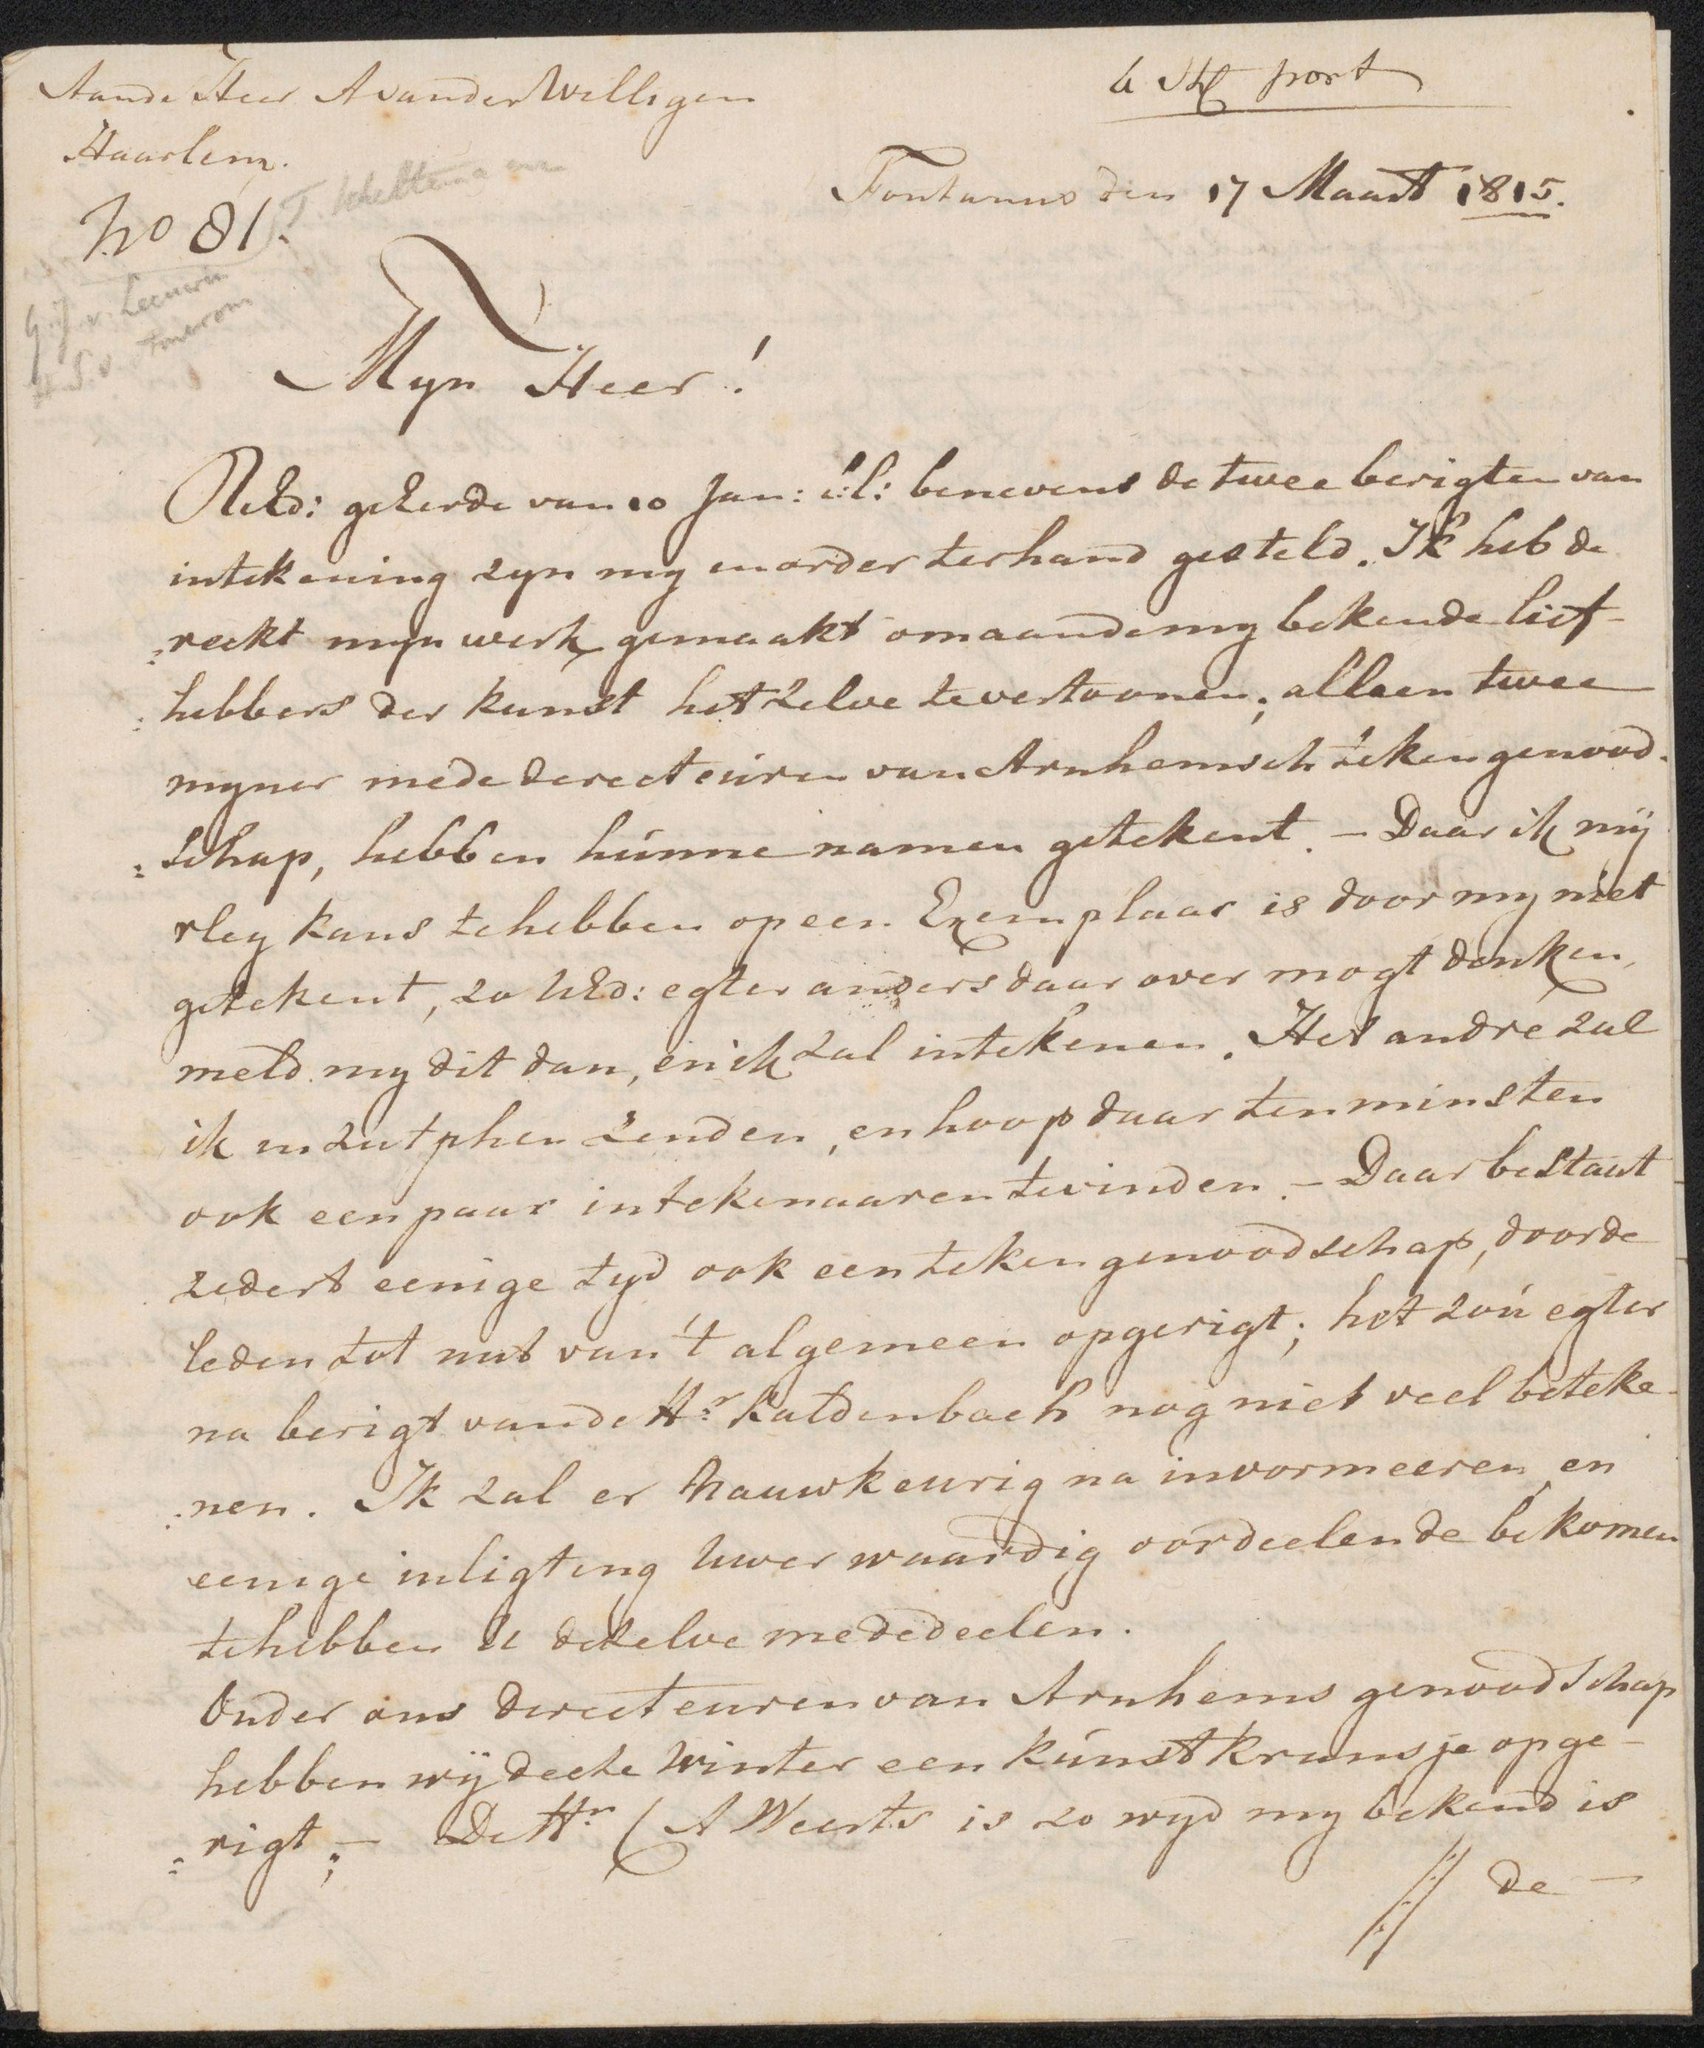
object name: letter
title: Brieven aan Adriaan van der Willigen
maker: taco scheltema (i)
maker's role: draughtsman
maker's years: 1760-1837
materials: ink, paper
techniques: pen, writing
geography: huize fontanus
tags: rotterdam, haarlem, adriaan van der willigen, deventer, the hague, coenraad alexander weerts, drawing, painting (including book-illumination, miniature-painting), art collecting, historical persons (portraits and scenes from the life), arnhem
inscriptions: collector's mark: ‘RPK’